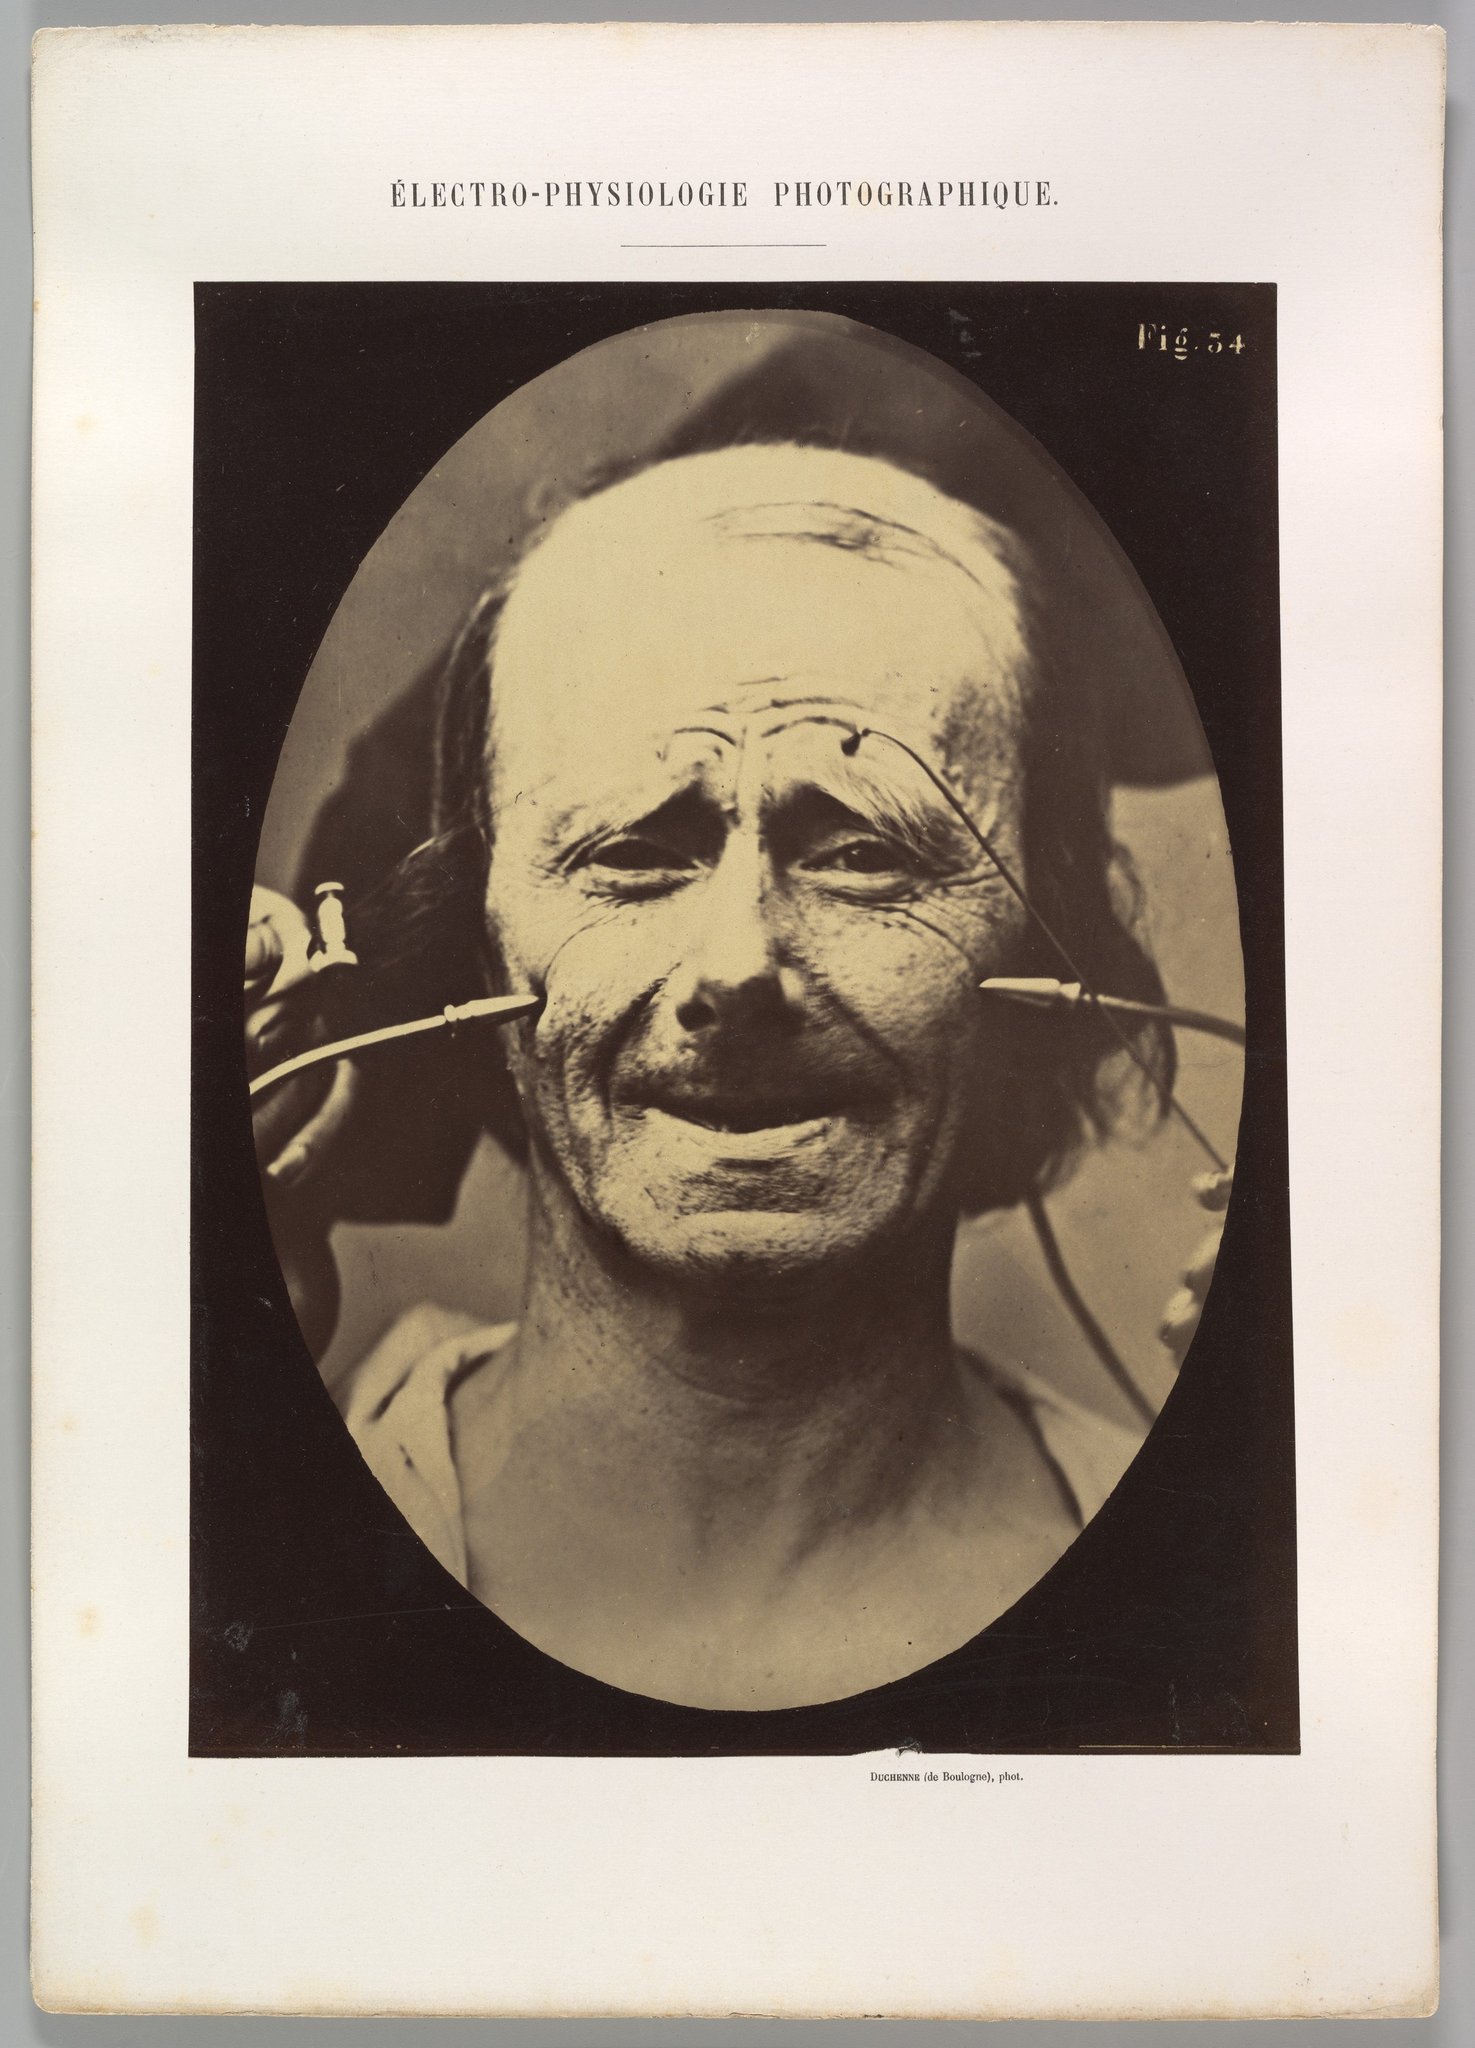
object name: photograph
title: Figure 34: Grimace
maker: guillaume-benjamin-amand duchenne de boulogne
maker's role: artist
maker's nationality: french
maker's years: 1806-1875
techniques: albumen silver print, glass negative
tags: science,men,portraits